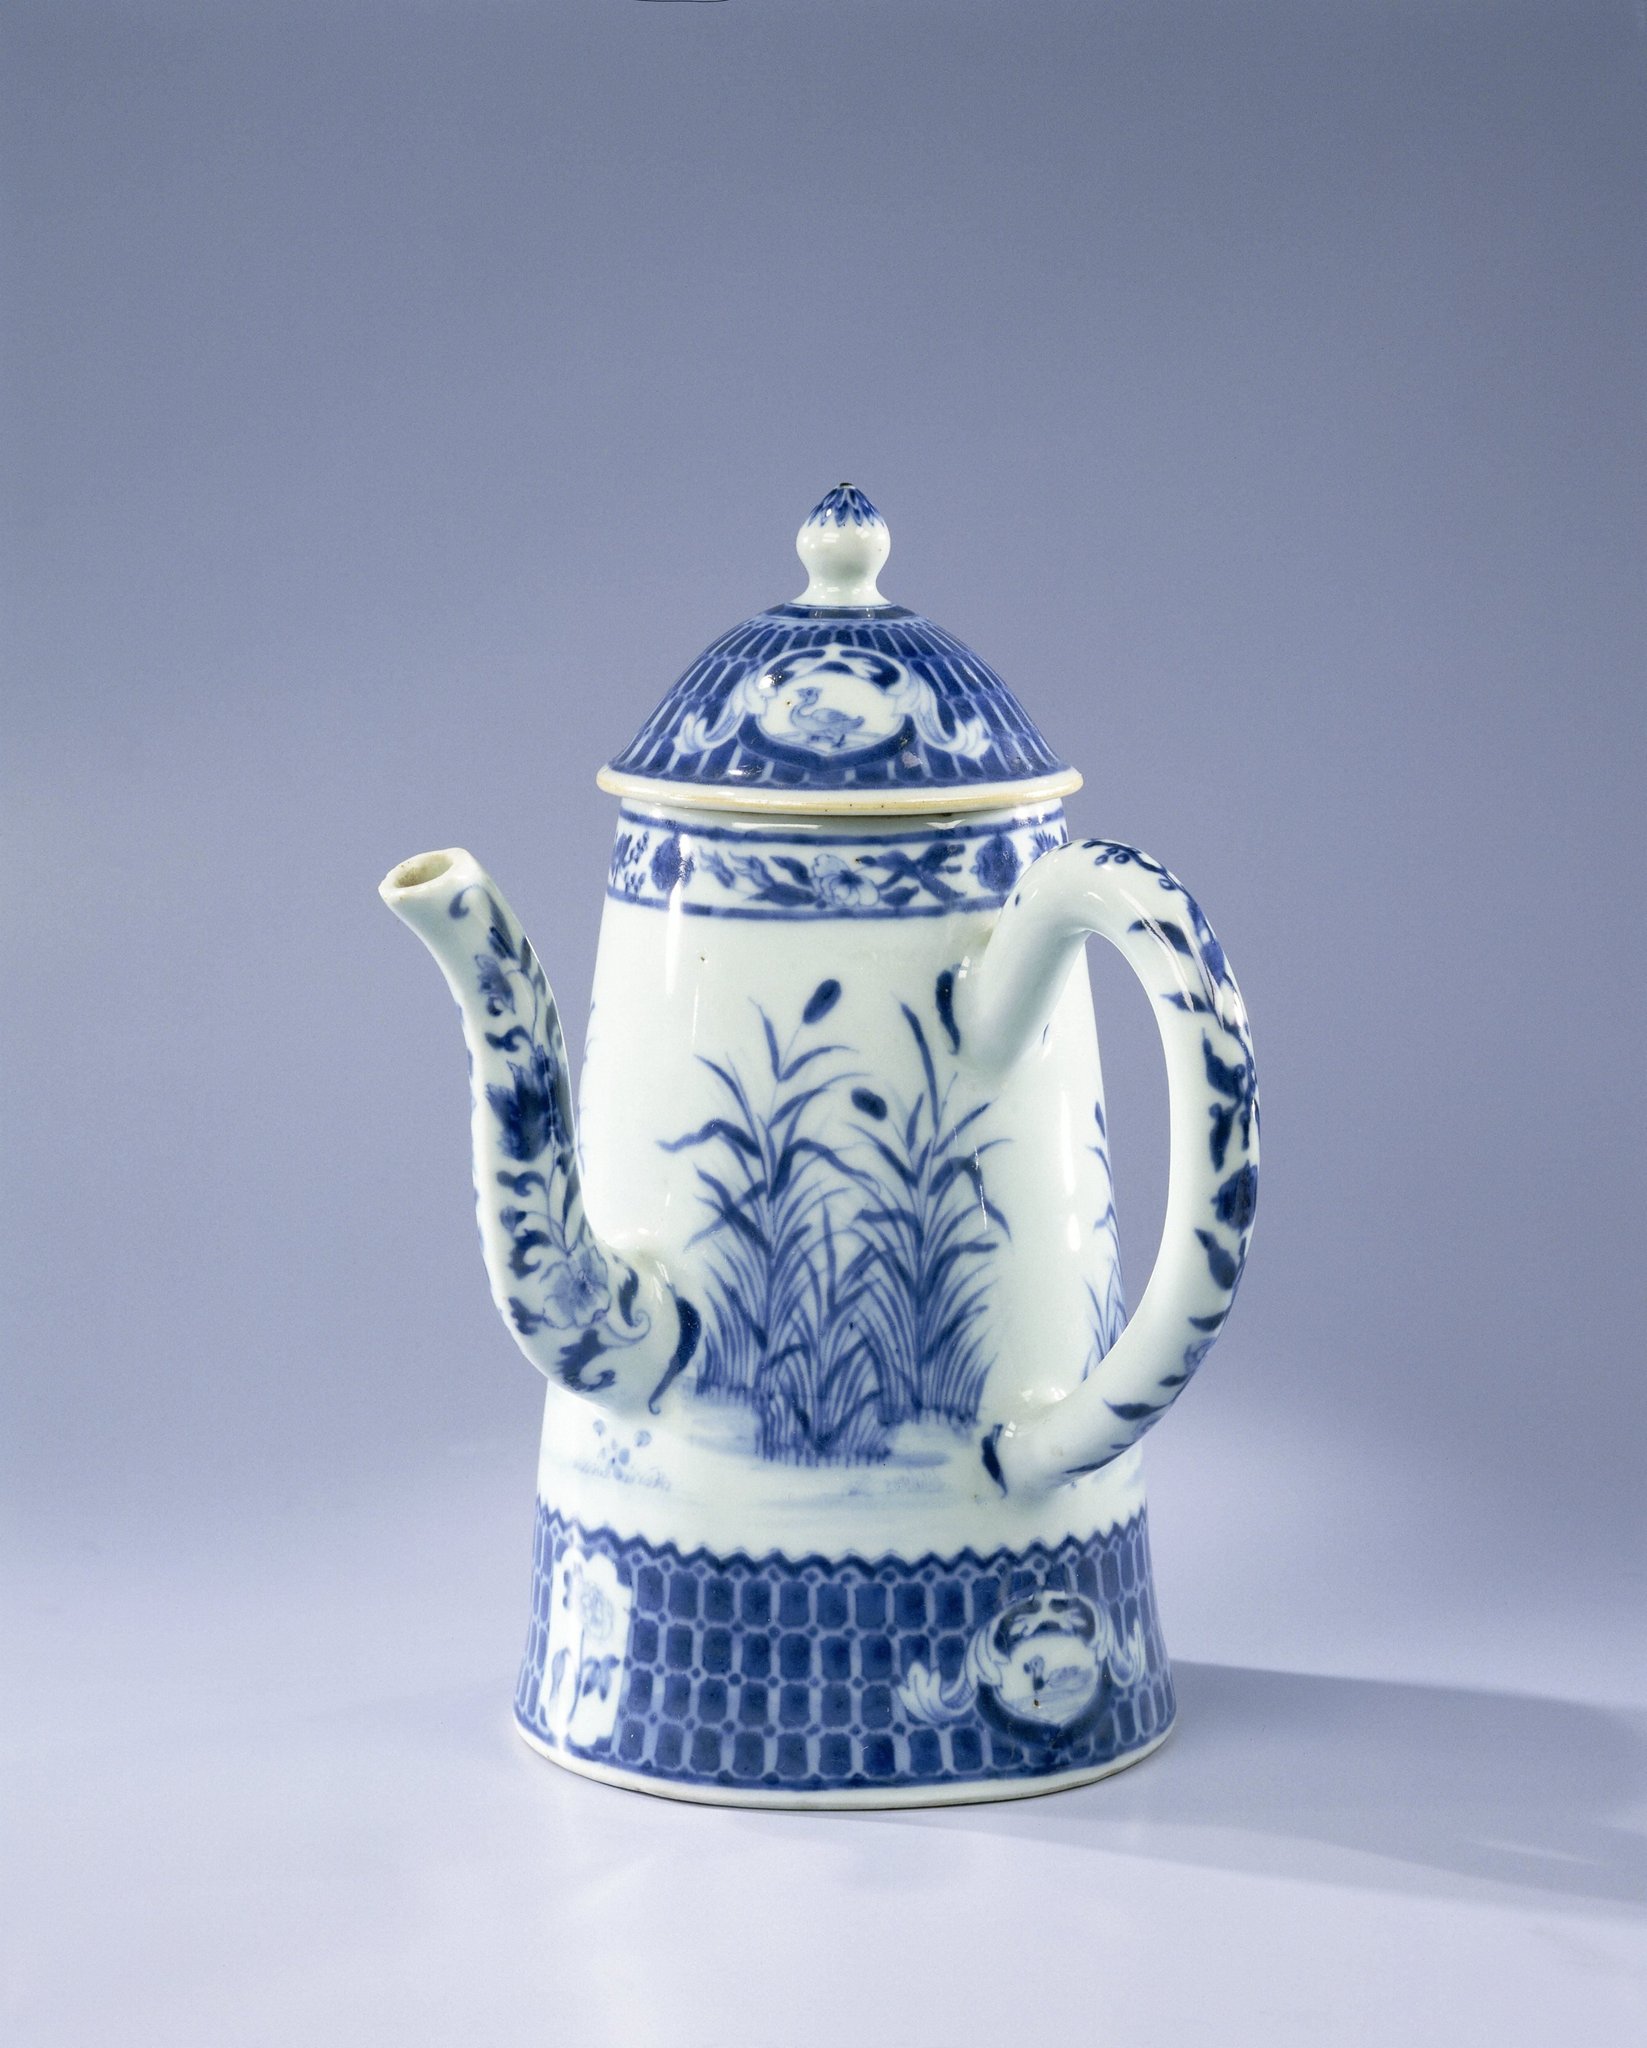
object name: coffee pot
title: Conical coffeepot with an image of The Parasol Lady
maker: Anonymous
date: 1736-1740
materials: cobalt, glaze, paint, porcelain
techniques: firing, turning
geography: china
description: Cilindrische koffiepot op een lage voetring, het handvat in een hoek van 45 graden geplaatst ten opzichte van de tuit. Een gewelfd deksel met een knop. Gedecoreerd in onderglazuur blauw met een voorstelling van de Parasoldames naar een ontwerp van Cornelis Pronk (1691-1754). De onderste sectie is gedecoreerd met een honingraatpatroon onderbroken door cartouches met vogels en bloemen. Dezelfde versiering op de deksel. Bestellingen van theeserviezen met Pronk-decors zijn in de VOC-archieven terug te vinden, maar helaas wordt niet vermeld of daar ook koffiepotten zoals deze toe behoorden. In totaal werden vier serviezen met Pronk-decors tussen 1737 en 1738 naar Nederland verscheept. De uitvoering van deze koffiepot is opmerkelijk omdat in geen van de cartouches een dame is afgebeeld zoals op de andere voorwerpen met het ontwerp van de Parasoldames. In plaats daarvan is een bloem afgebeeld. Wellicht gaat het hier om een privé-bestelling uit dezelfde periode. Ook andere ontwerpen van Pronk komen op dit type koffiepotten voor. Het Museum Guimet te Parijs bezit een identieke koffiepot met het Prieel, een ander ontwerp van Pronk.